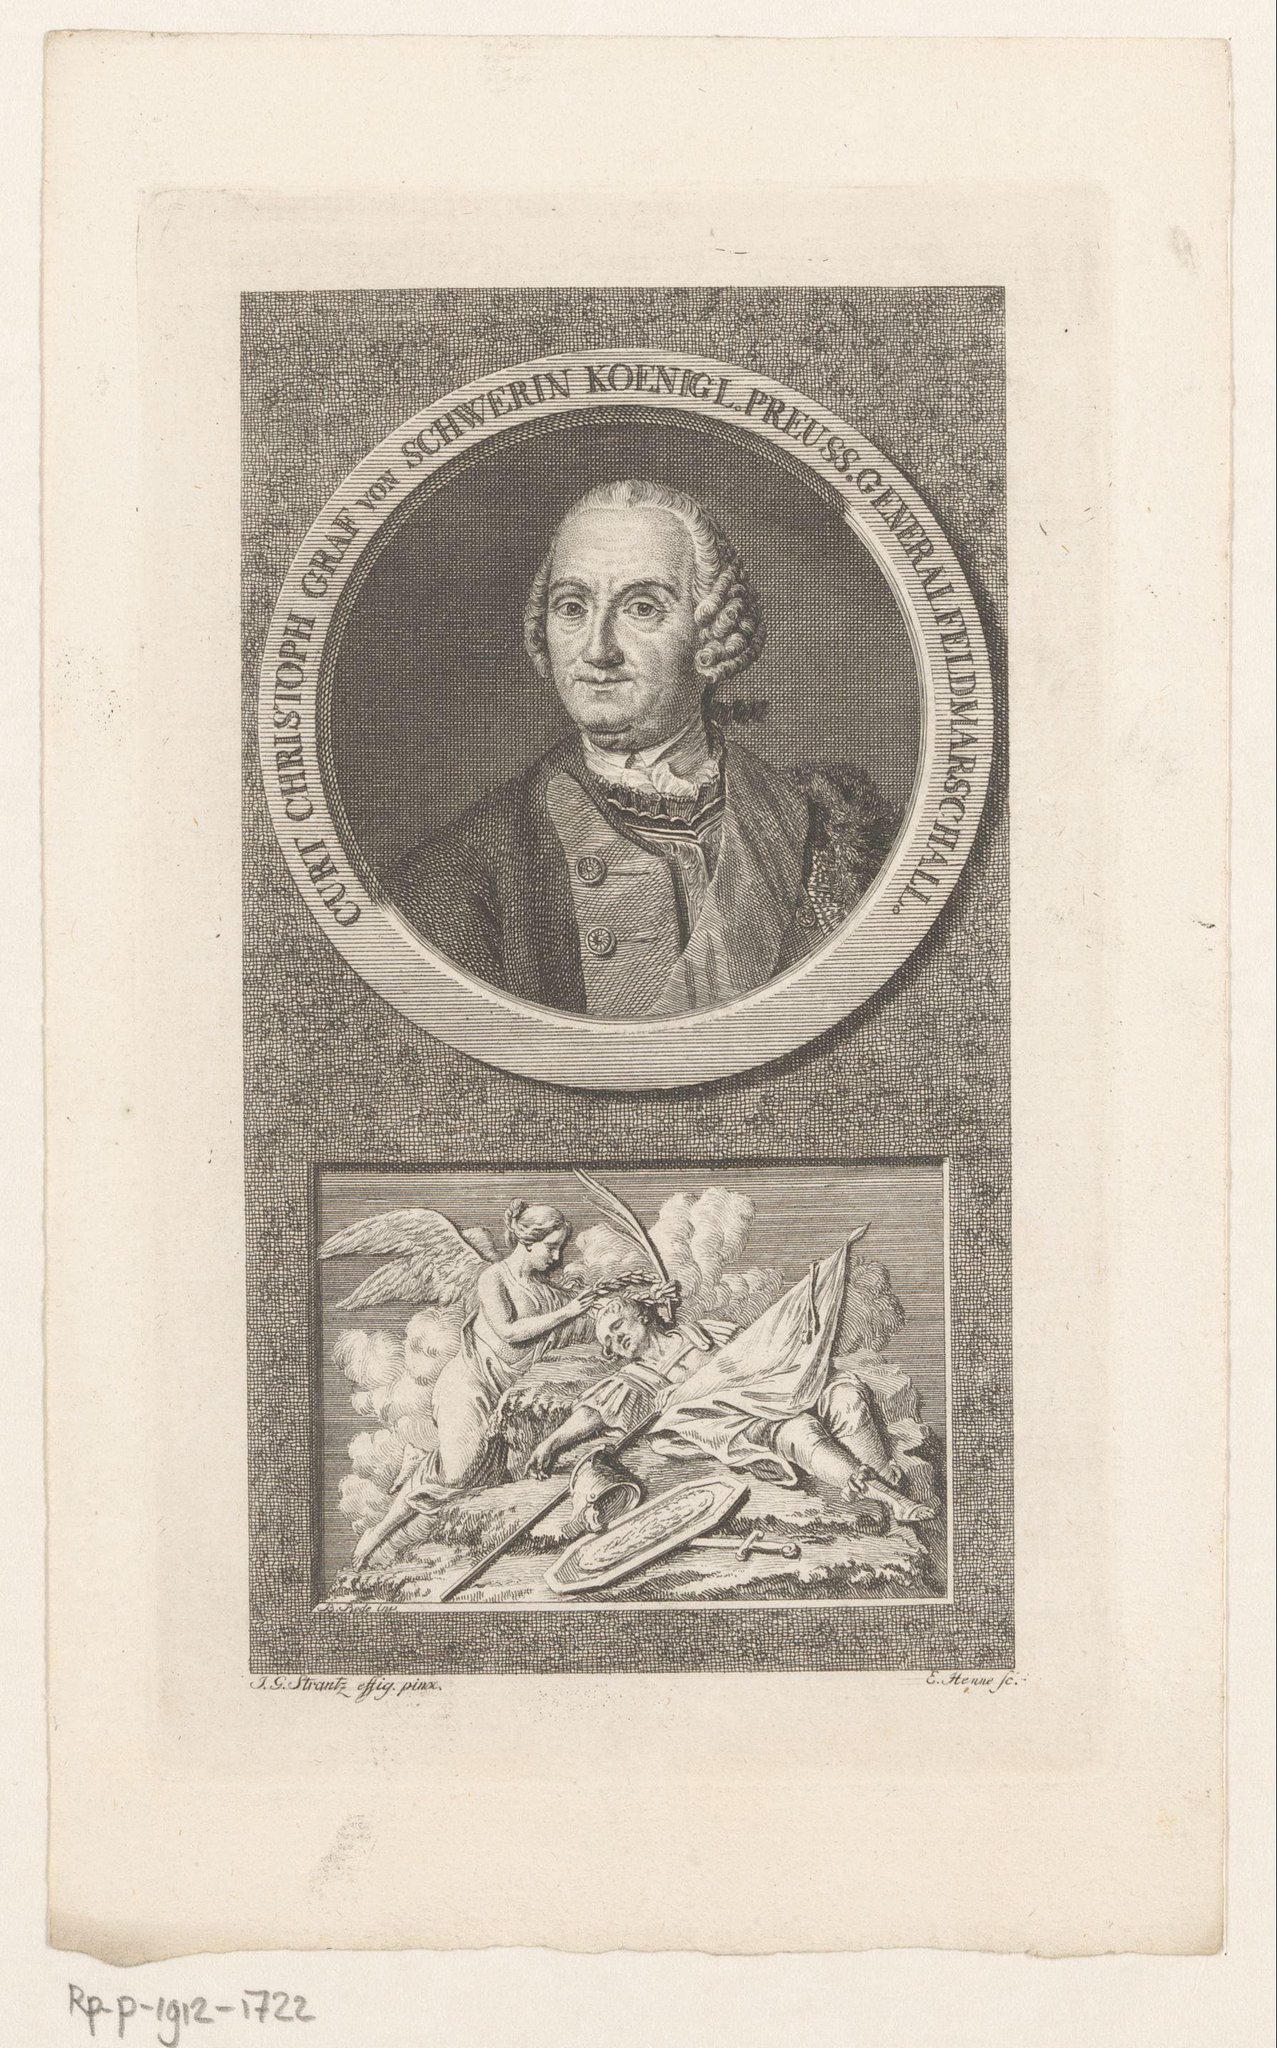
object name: print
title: Portret van Kurd Christoph von Schwerin en een allegorie op sterven op het slagveld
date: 1769-1828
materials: paper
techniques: engraving, etching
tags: commander-in-chief, general, marshal, historical persons, crowning with laurel, the defeated (after the battle)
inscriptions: collector's mark: Lugt 2228